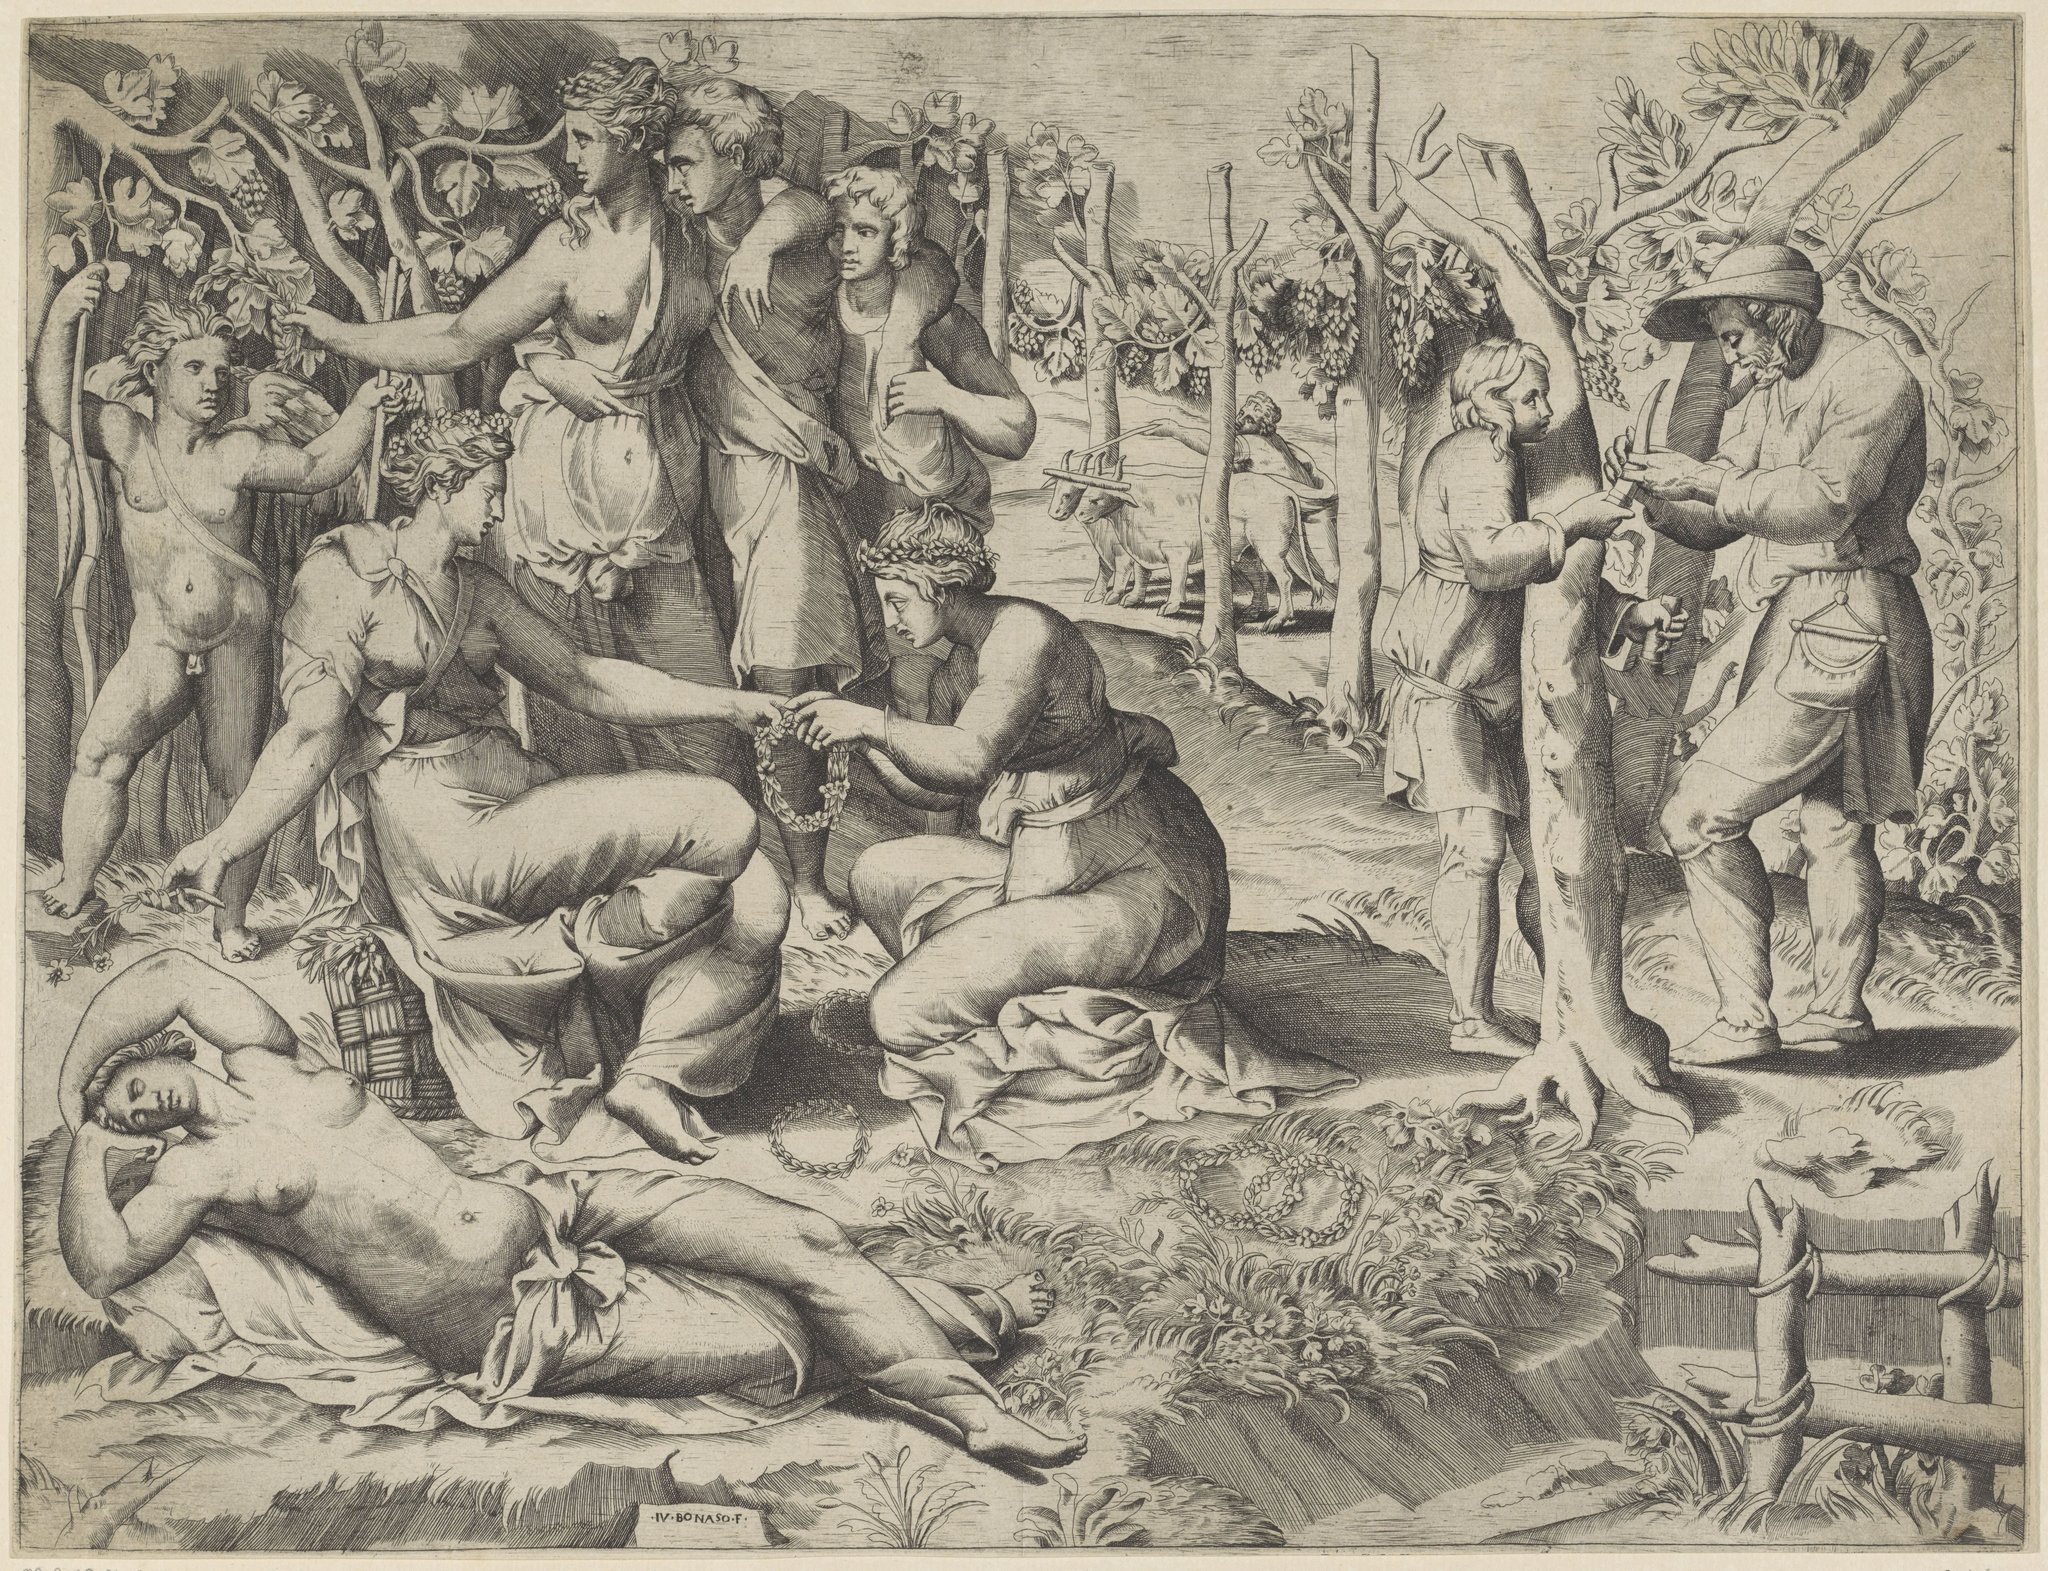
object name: print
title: Flora geeft een krans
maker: giulio bonasone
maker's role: painter, print maker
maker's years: 1510-1576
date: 1501-1580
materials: paper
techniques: engraving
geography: mantua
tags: vineyard, nymphs (in general); 'ninfe in commune' (ripa), (story of) flora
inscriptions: collector's mark: Lugt 240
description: Flora geeft een krans aan een vrouw die voor haar geknield zit in een wijngaard. Ze worden omringd door verschillende figuren, onder wie Amor. Rechts een man en een jongen bij een boom. Op de voorgrond links ligt een nimf.